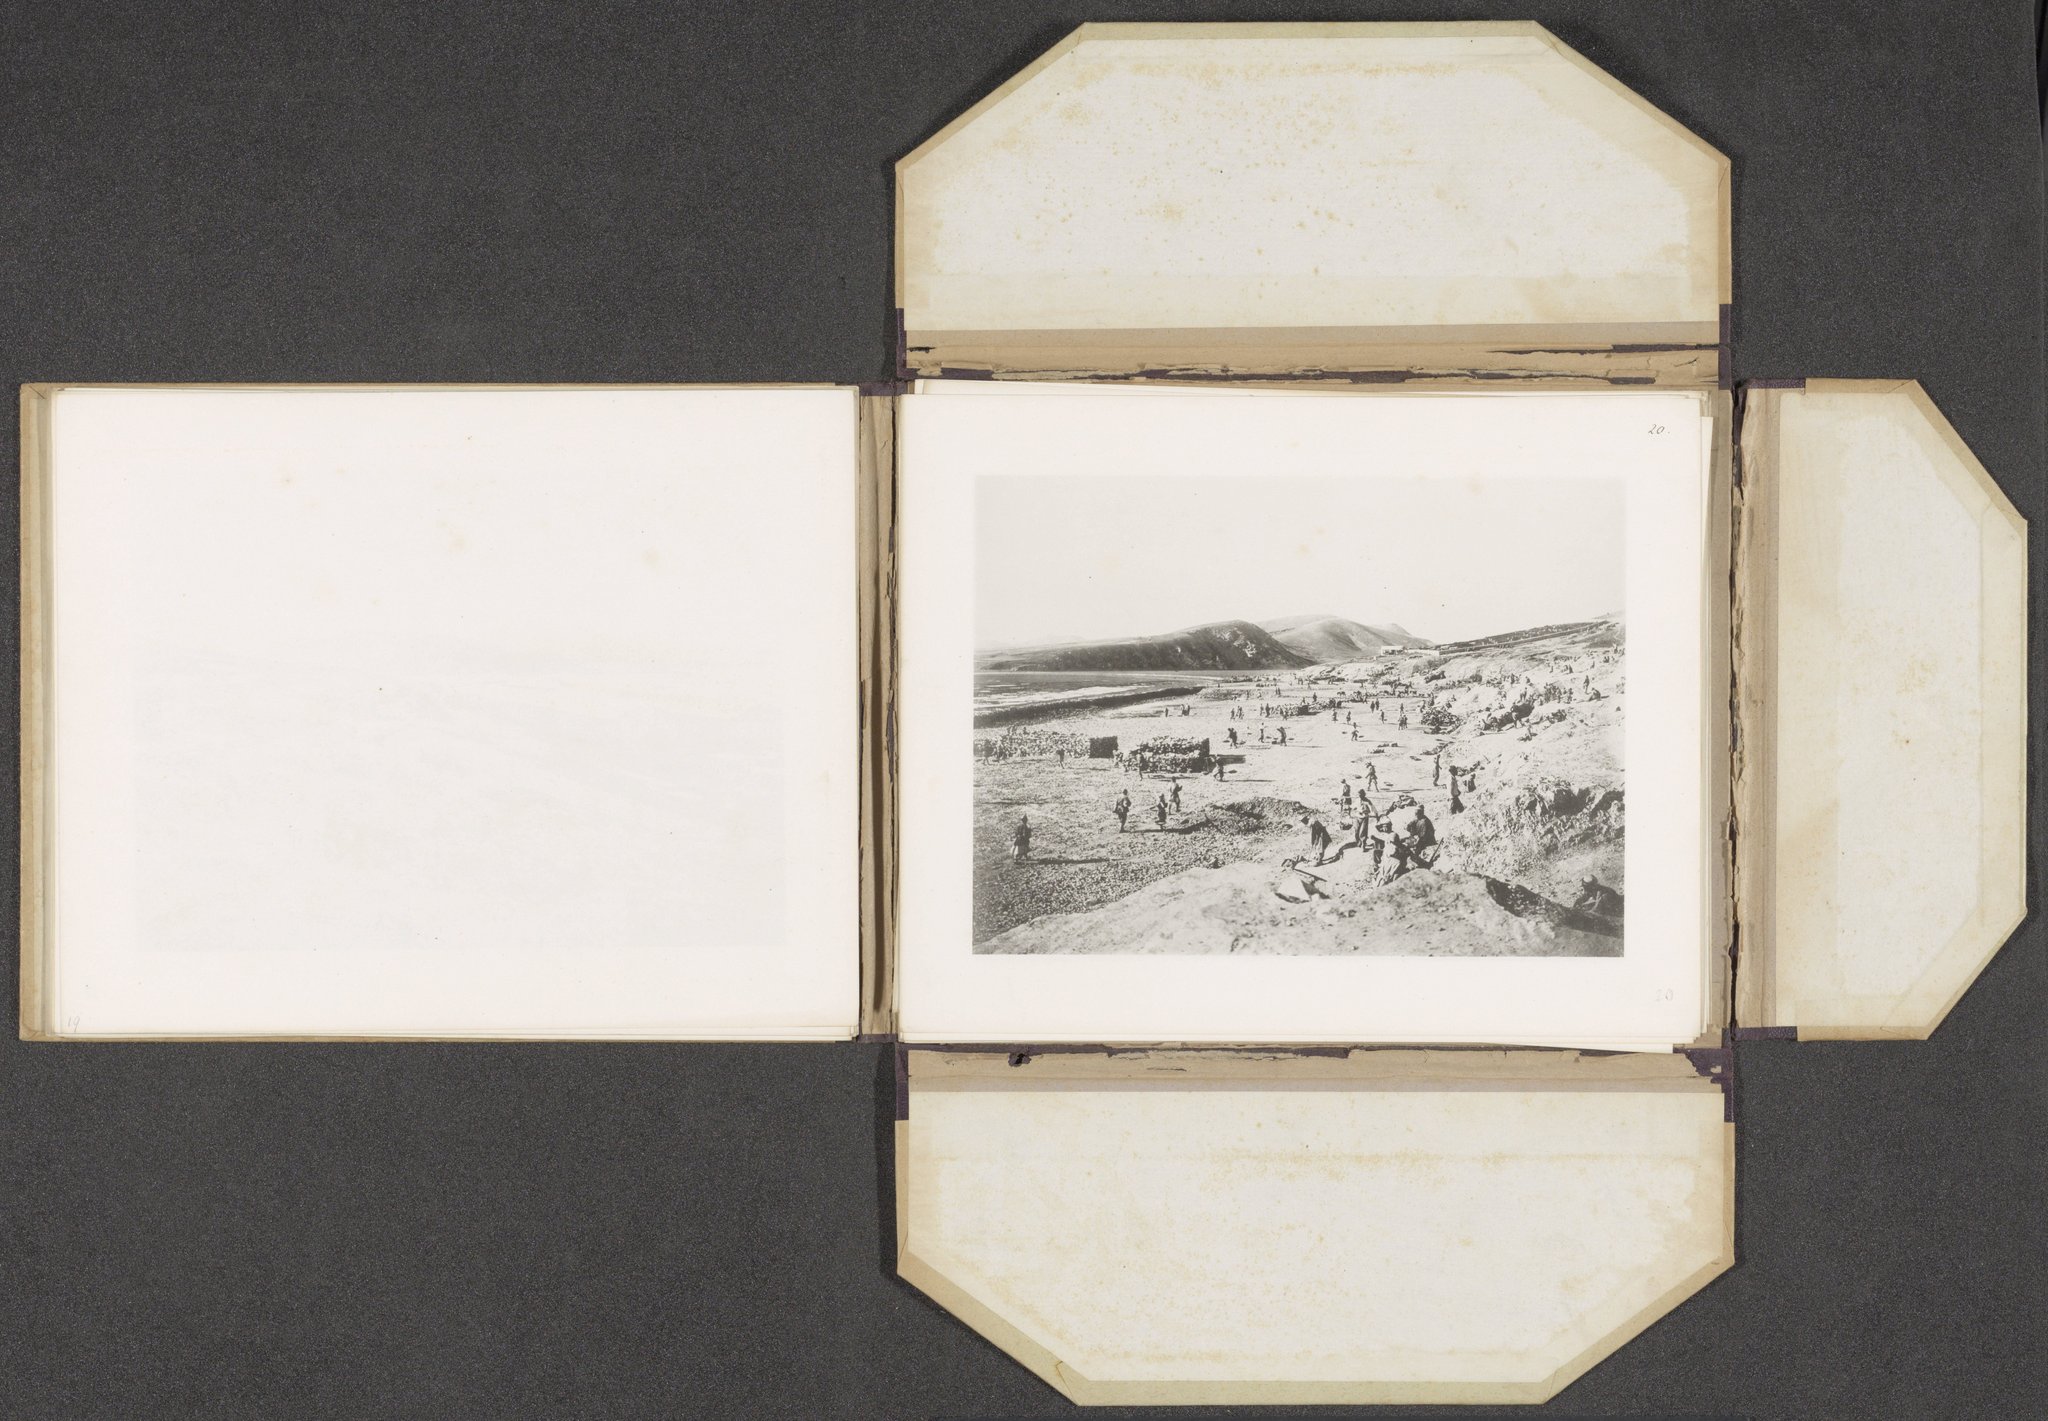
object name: page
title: Arbeiders bereiden de aanleg van een spoorlijn voor te Port Arthur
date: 1898-1899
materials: paper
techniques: photograph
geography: port arthur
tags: working class, labourers, railway, tramway; rack railway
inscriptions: number: ‘20’